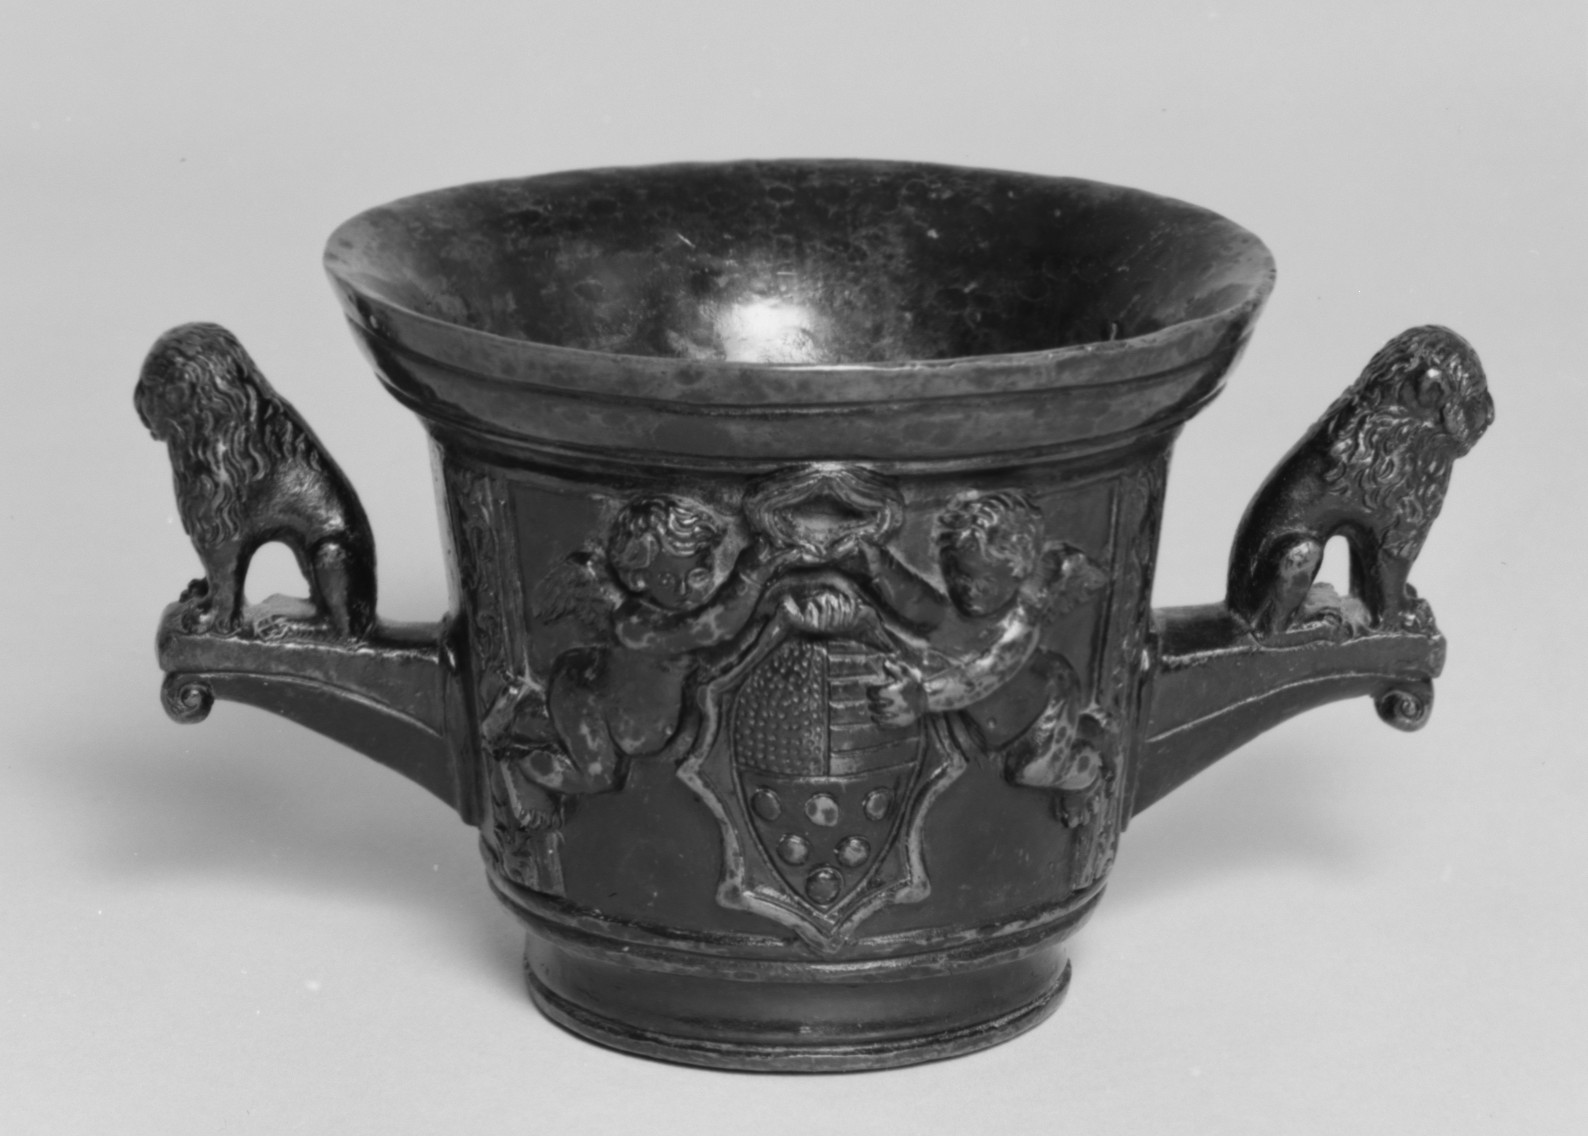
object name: mortar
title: Medieval-Renaissance style mortar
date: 1801-1900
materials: bronze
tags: lions,coat of arms